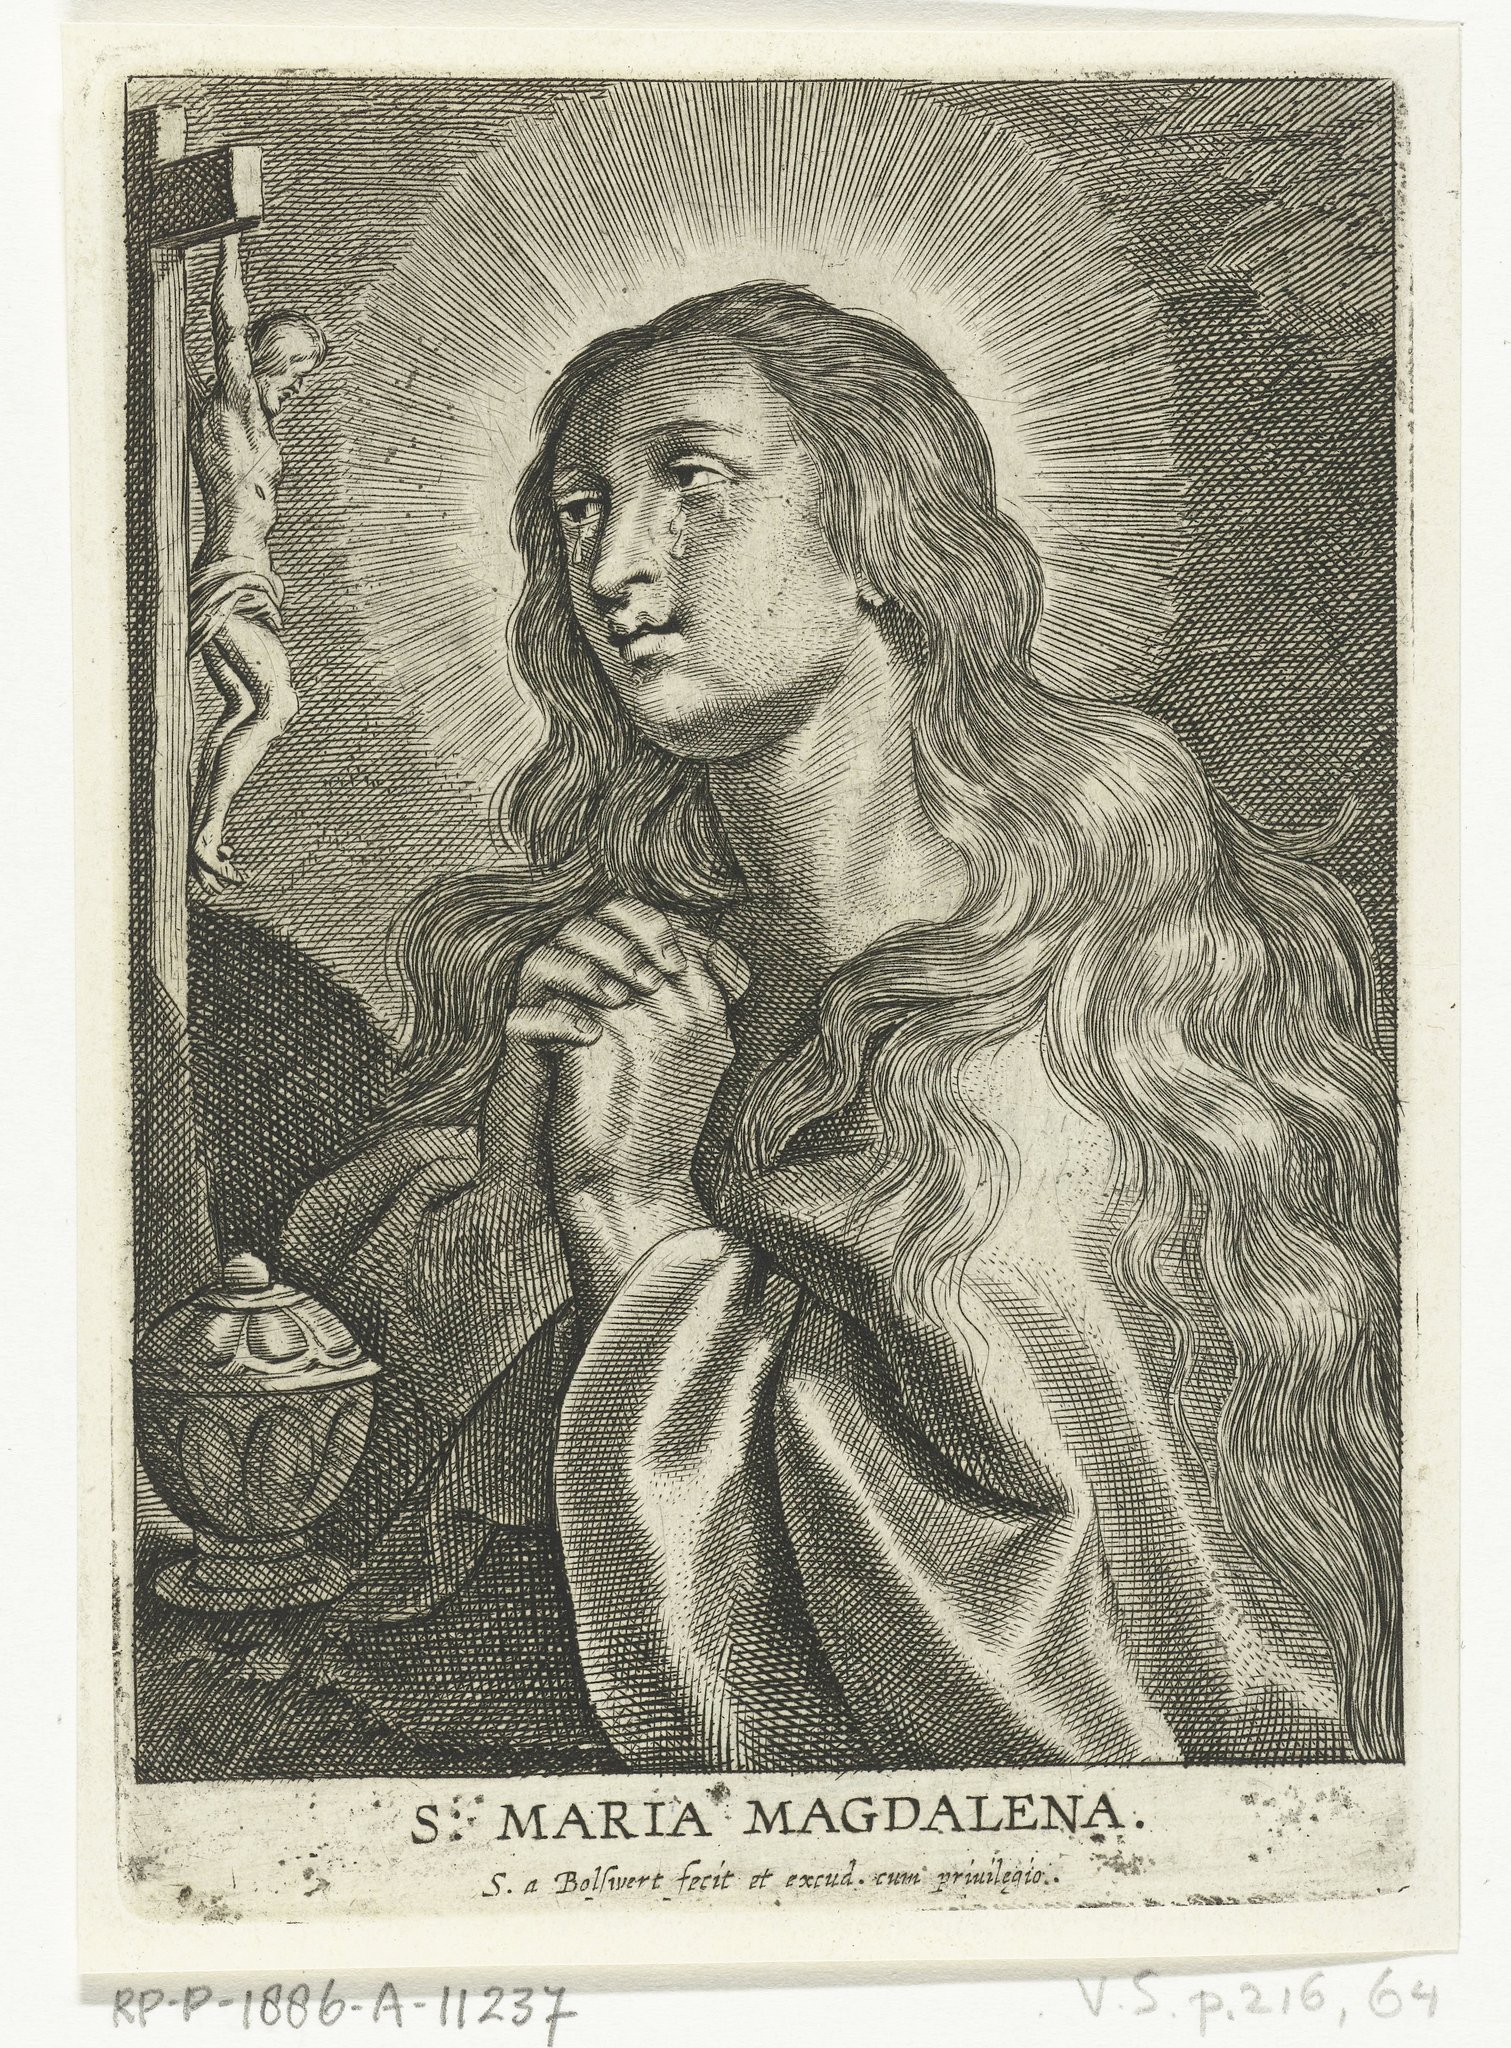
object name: print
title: S. Maria Magdalena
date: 1596-1659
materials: paper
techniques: engraving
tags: personal devotion of st. mary magdalene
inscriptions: collector's mark: Lugt 2228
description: Prent uit serie Vélins met negentig prenten naar ontwerp van Peter Paul Rubens. In de bronnen vinden we uiteenlopende gegevens over aantal en samenstelling van de serie. Hollstein hanteert het aantal van negentig prenten. De reeks Vélins in de collectie van het RMA bevat verschillende staten afkomstig uit meerdere uitgaven welke moeilijk te duiden zijn. Sommige dragen het originele adres van Schelte Adamsz. Bolswert als graveur en uitgever, op andere exemplaren is deze naam verwijderd (duidelijk zichtbaar!) en vervangen door de naam Cornelis Galle (II). De prenten met de naam van uitgever Galle zijn vaak opgewerkt. We treffen nog een andere naam van een uitgever bij enkele prent aan: Martien van den Enden. Herkomst uit meerdere uitgaven spreekt ook uit afwijkende opschriften in Nederlands en Latijn en variaties op dezelfde thema's welke misschien nooit langs elkaar in dezelfde serie gebruikt werden.